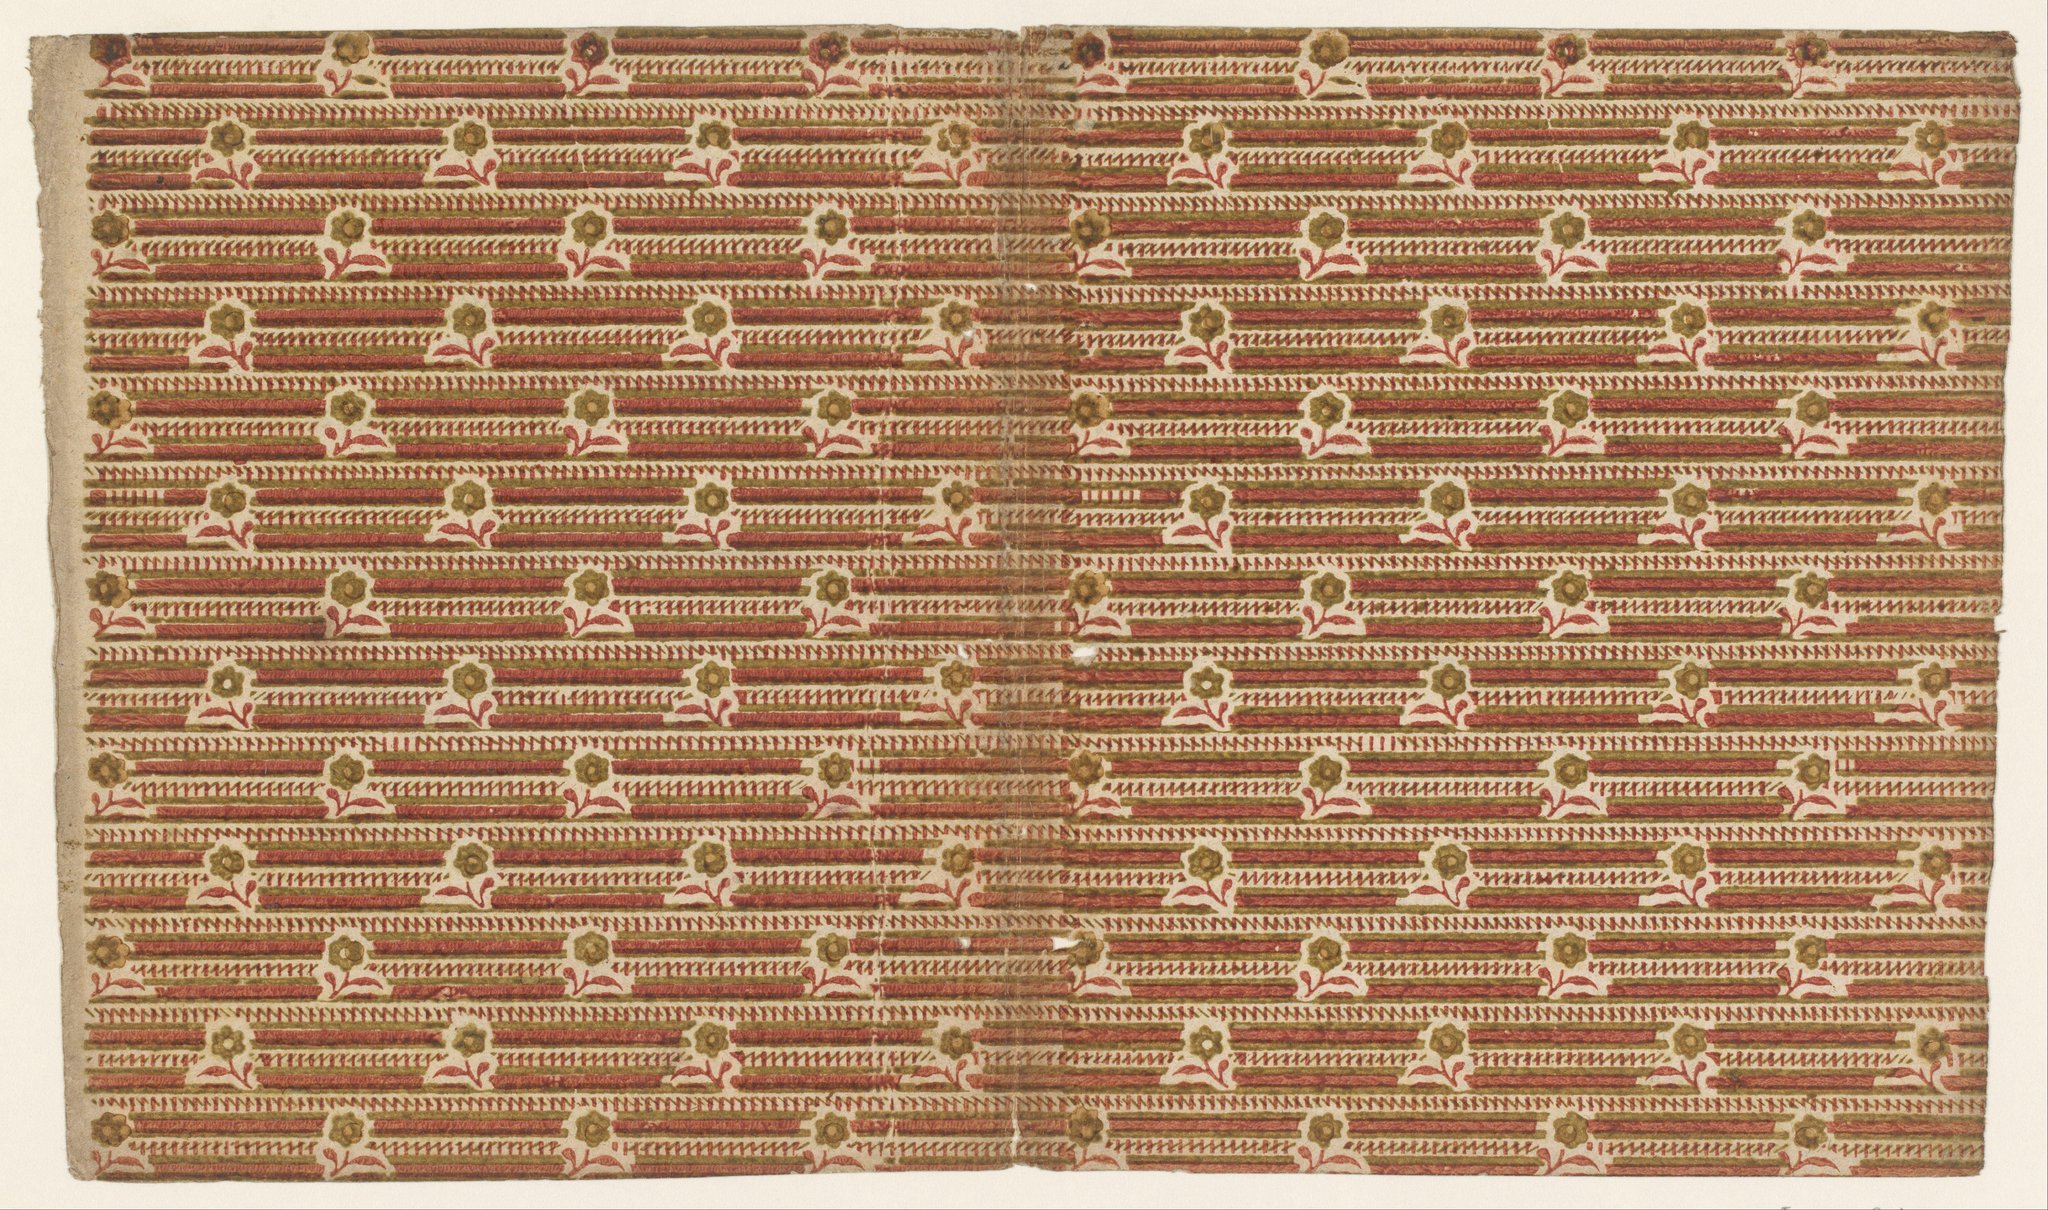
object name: wrapper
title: Blad met uitgespaarde bloemen op lijnenfond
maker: Anonymous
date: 1700-1850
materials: paper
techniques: printing block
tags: ornament derived from plant forms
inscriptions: collector's mark: Lugt 2228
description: Blad met een lijnenfond met uitgespaarde bloemen. Gebruikt als omslag.